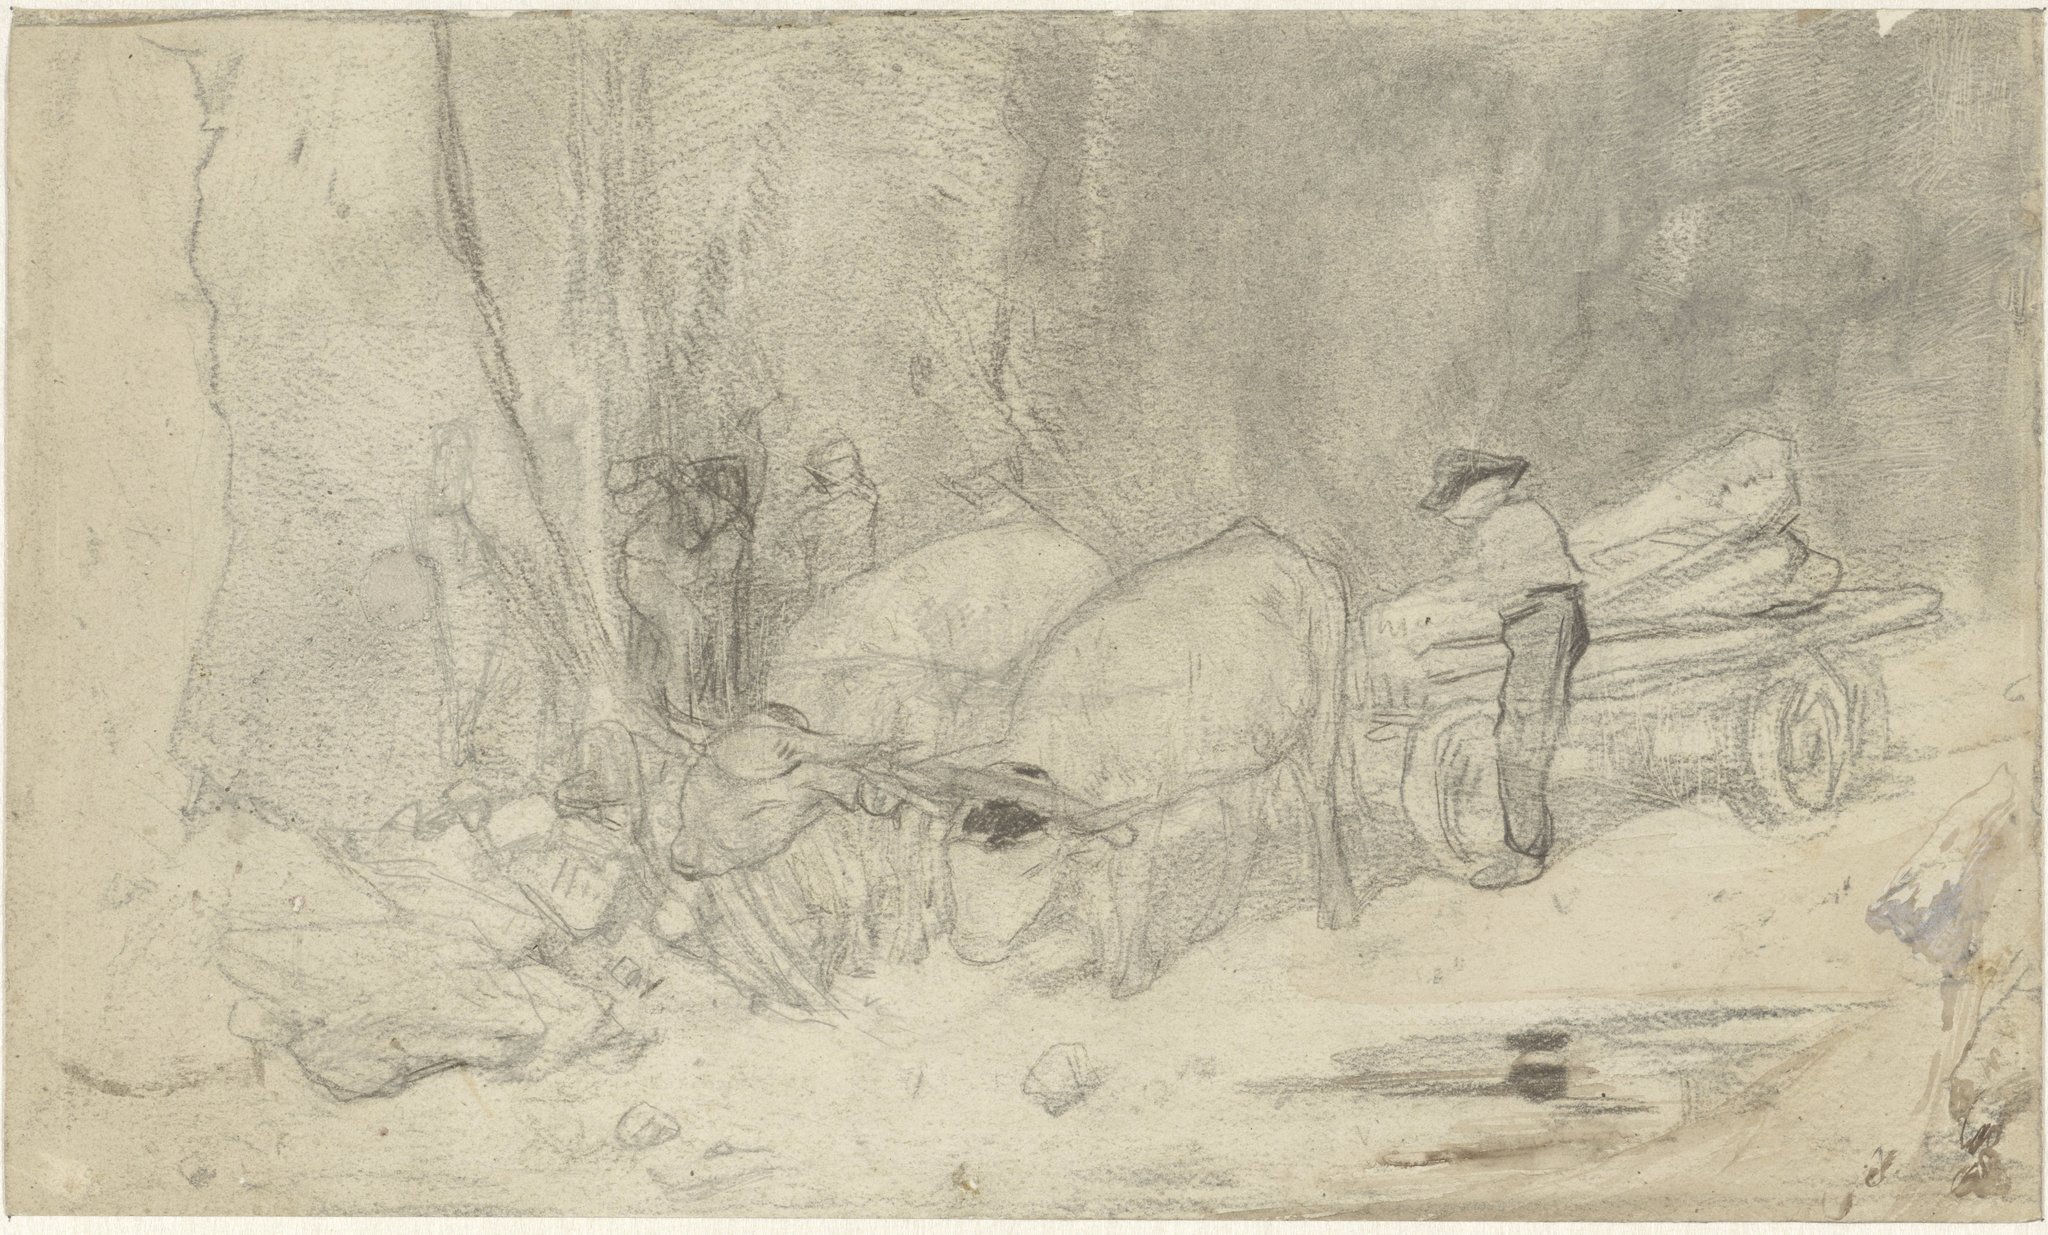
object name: drawing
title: Ossenwagen op bergweg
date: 1847-1899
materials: chalk, charcoal, paper, pencil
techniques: brush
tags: ox, (farm) wagon, freight wagon, cart